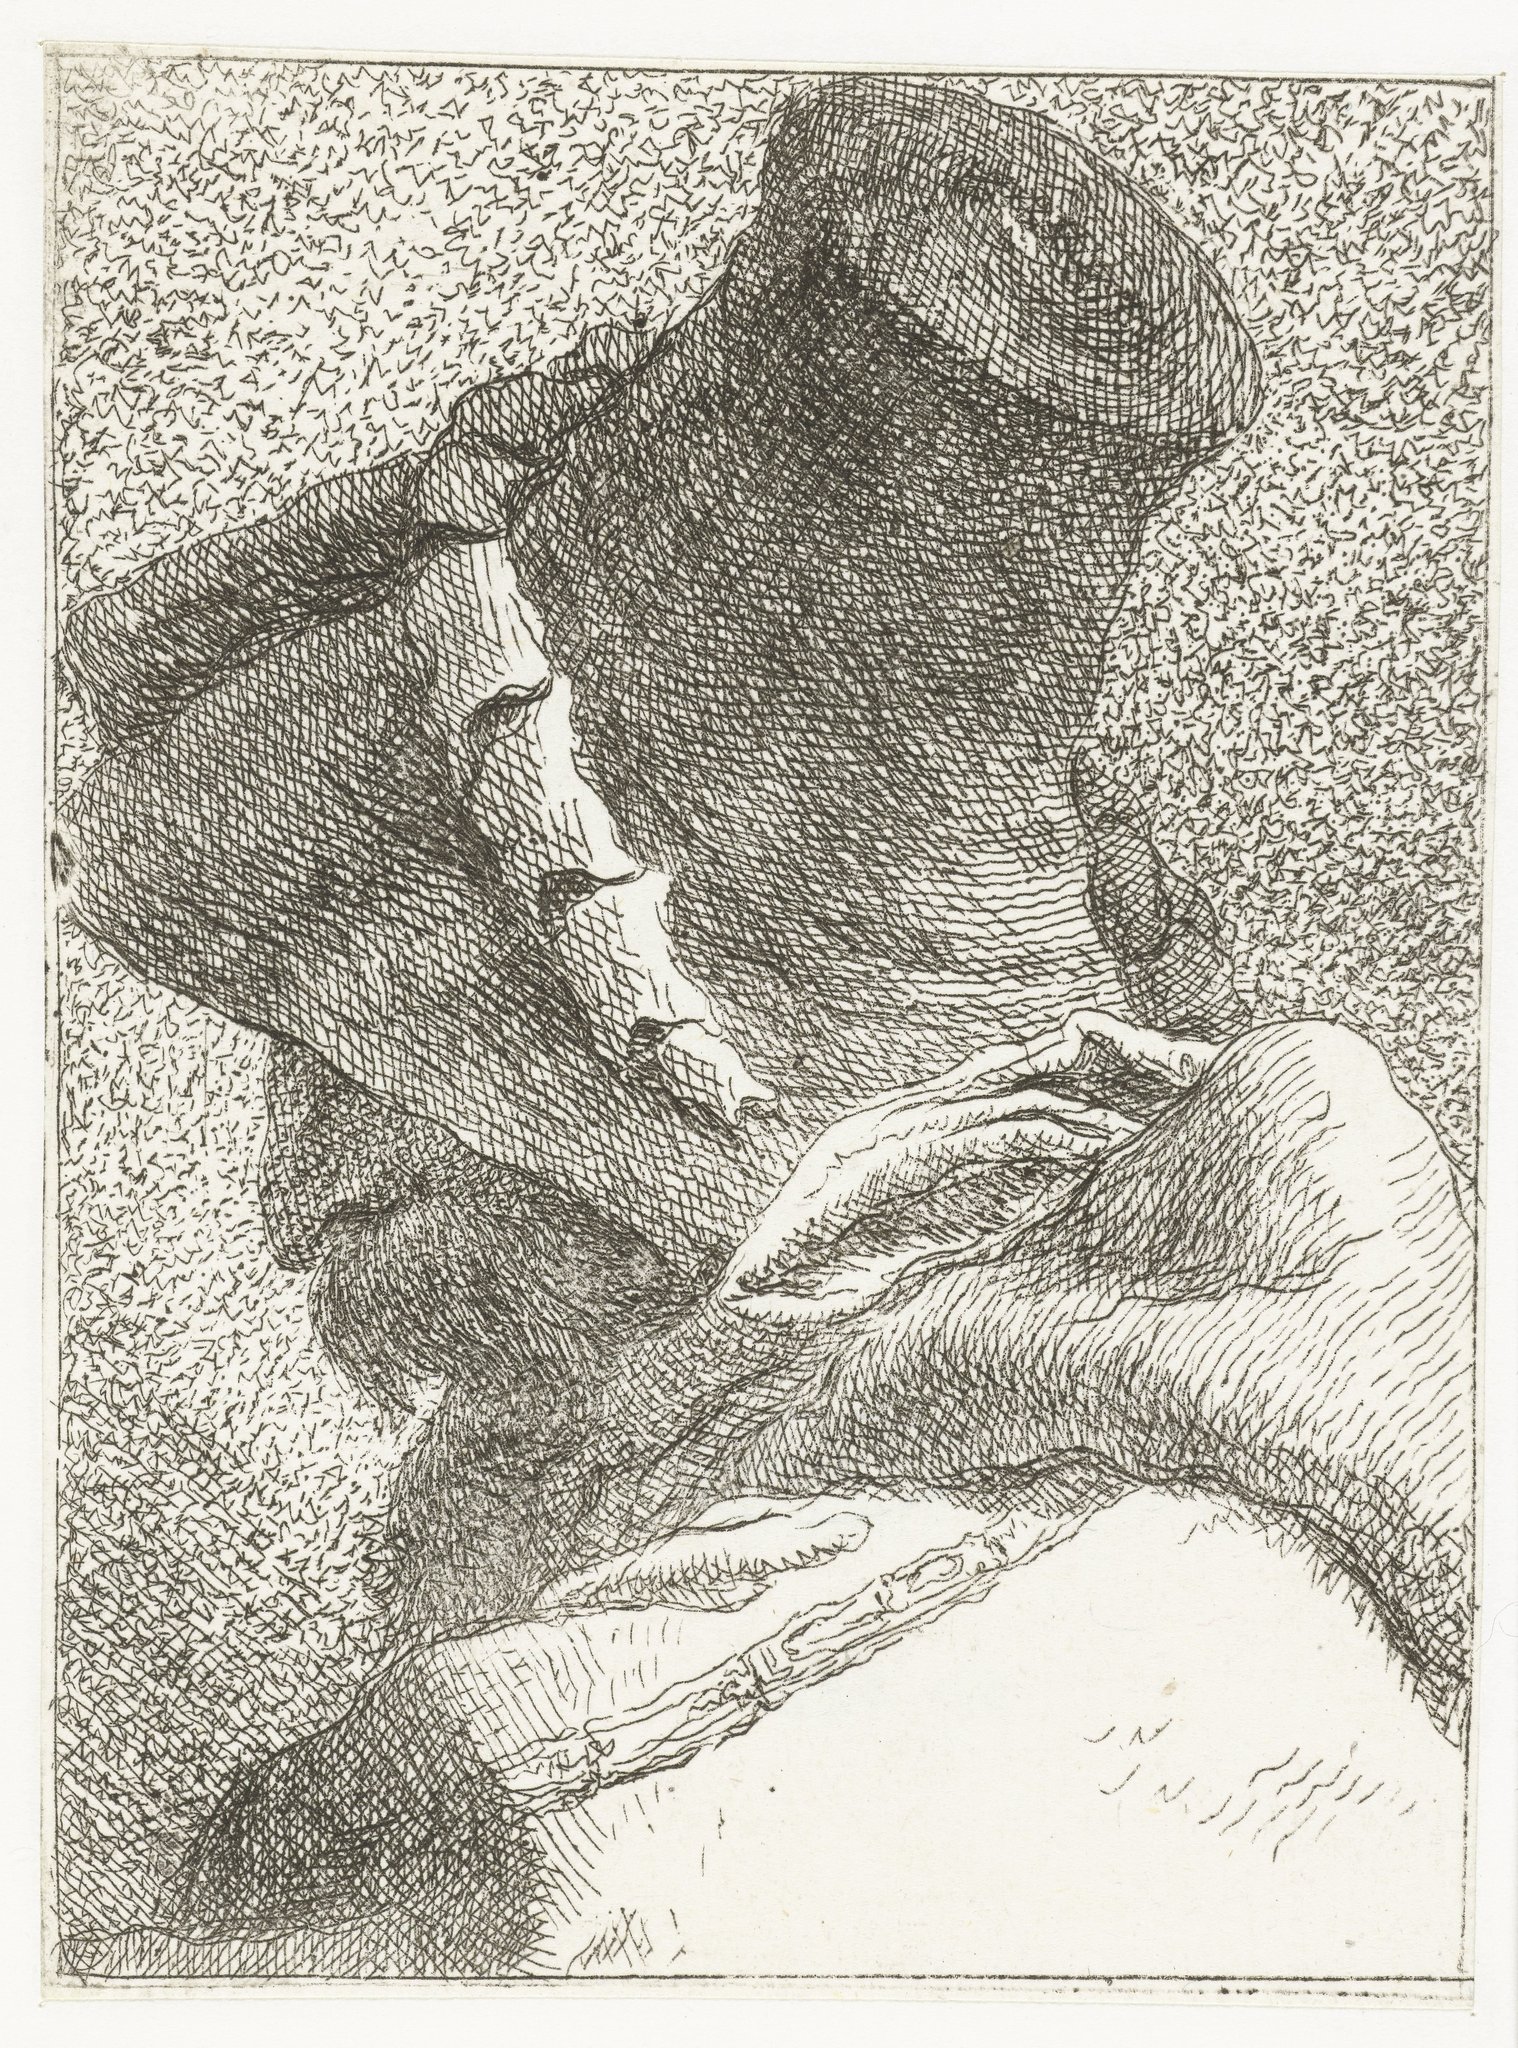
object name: print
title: Raccolta di Teste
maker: giovanni domenico tiepolo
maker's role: draughtsman, print maker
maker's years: 1727-1804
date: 1771-1774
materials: paper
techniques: etching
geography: venice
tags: head-gear: hat (+ men's clothes)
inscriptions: collector's mark: Lugt 2228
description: Prent uit serie Verzameling hoofden (Raccolta di teste). Giovanni Domenico Tiepolo vervaardigde in de winter van 1757-1758 en in de periode van 1771-1774 deze hoofden naar schilderijen en tekeningen van Giovanni Battista Tiepolo. De eerste uitgave verscheen in 1774 in twee delen met elk dertig prenten. Deze prent werd in de tweede staat met serienummer 18 opgenomen in deel 2.